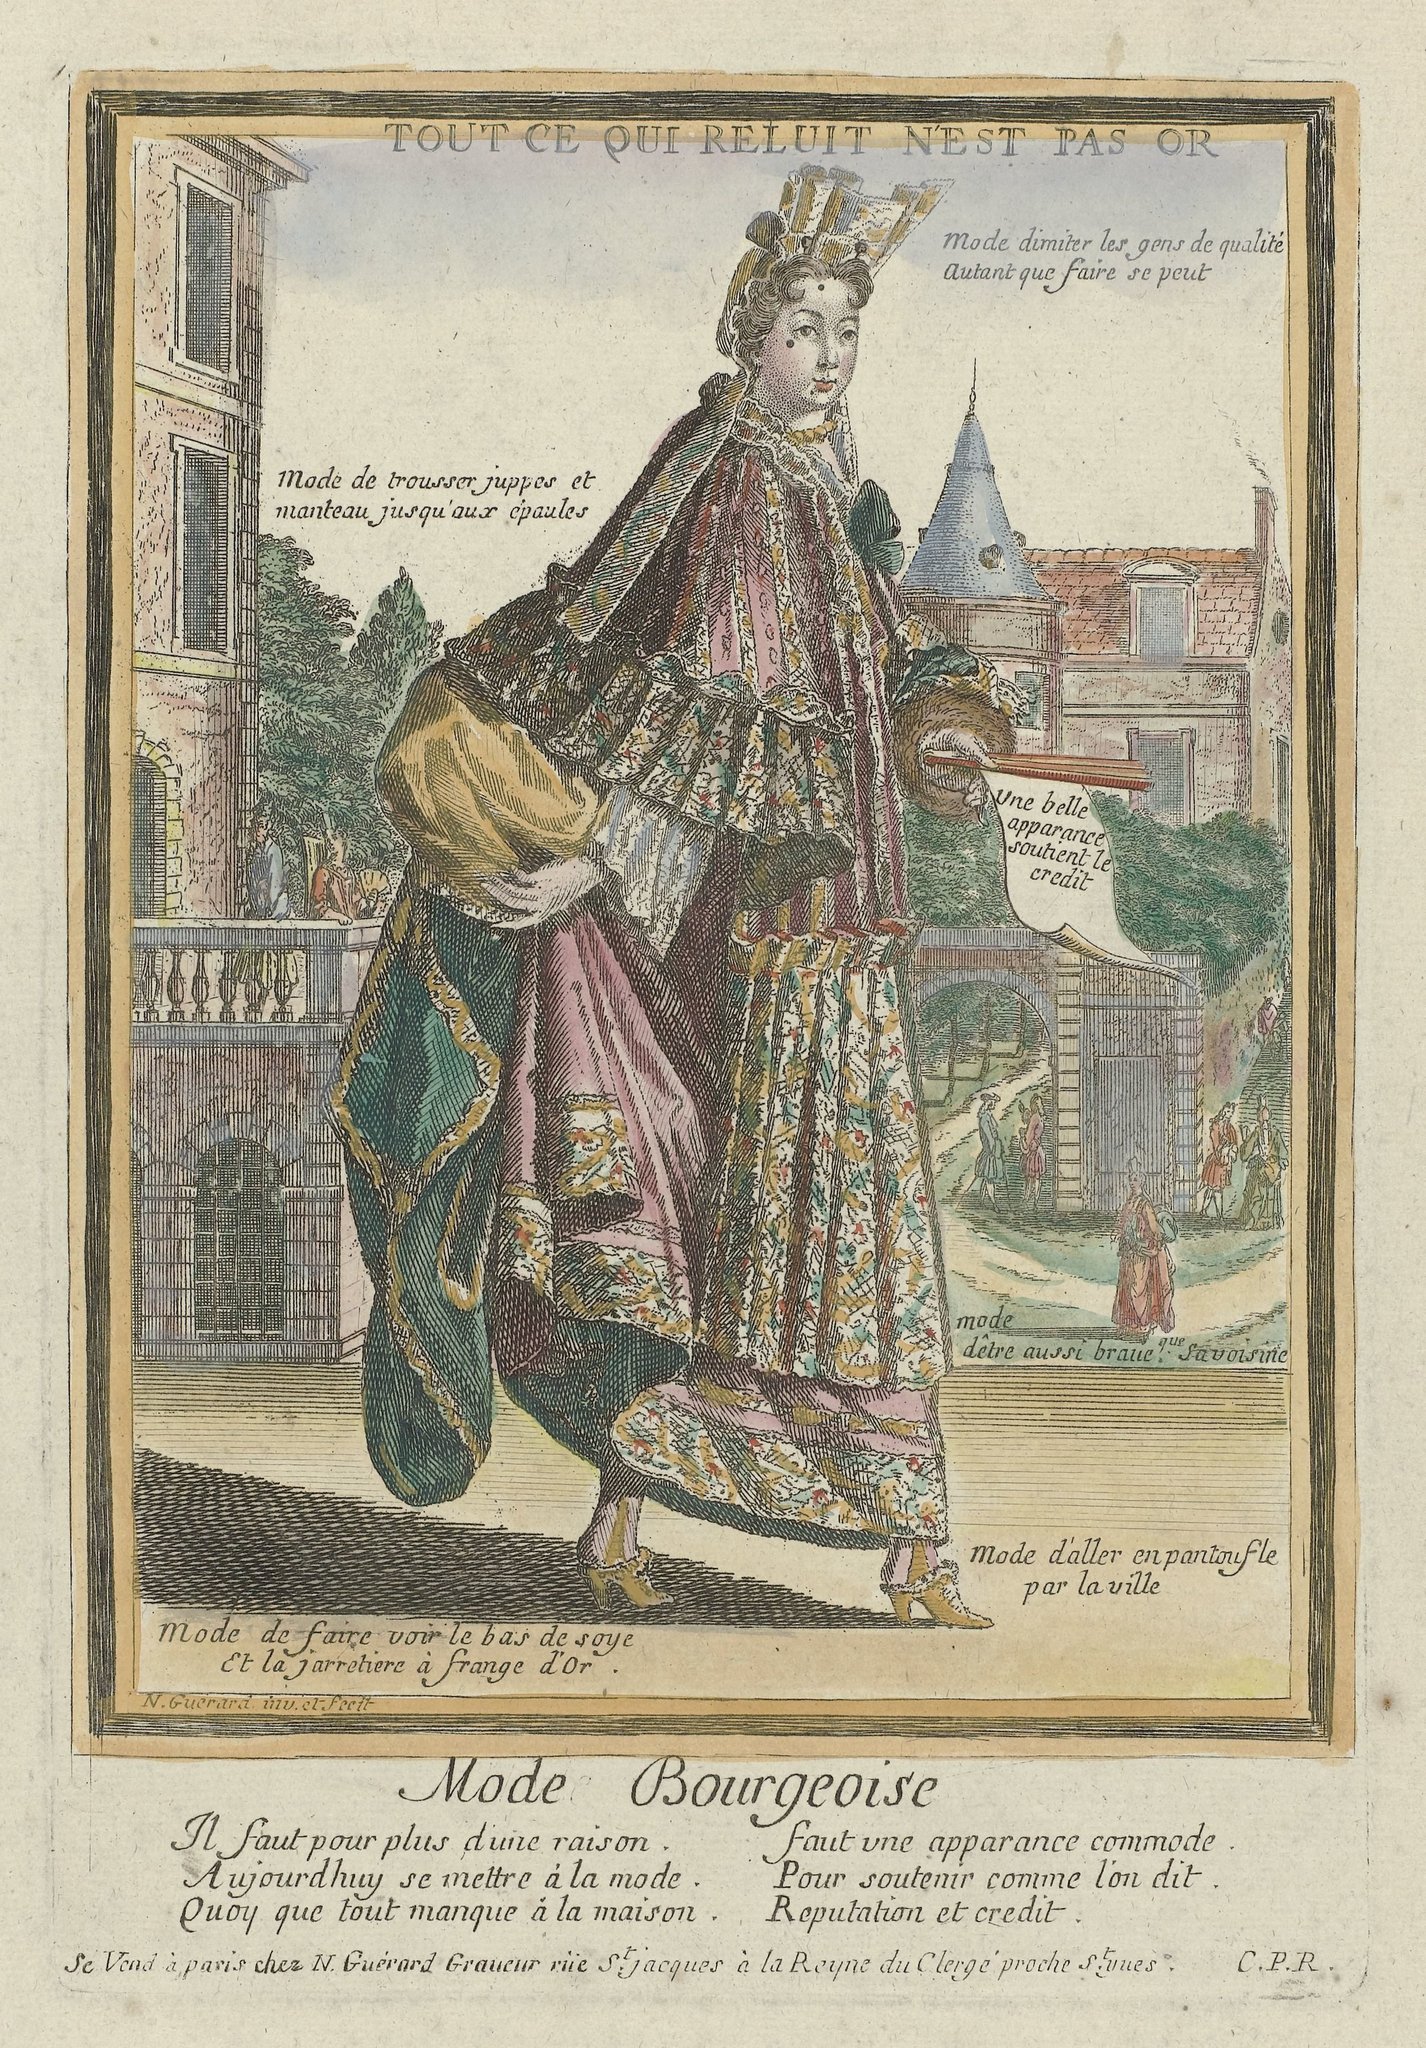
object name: costume print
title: Het is niet alles goud wat er blinkt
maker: nicolas guérard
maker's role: print maker, publisher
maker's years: 1648-1719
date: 1690-1693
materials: paper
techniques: engraving, hand coloring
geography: paris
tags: braces, suspenders, coat (+ women's clothes), styles of hairdress - aa - ~ women, fashion plates, shoes, sandals (+ women's clothes), dress, gown (+ women's clothes), fan, proverbs, sayings, etc., stockings, socks (+ women's clothes), head-gear: fontange (+ women's clothes), painting of body or face - aa - (for) women, necklace (+ women's clothes)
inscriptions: address: ‘Se vend à paris chez N. Guérard Graveur rue St. Jacques à la Reyne du Clergé proche St. Yves’, inscription: ‘Mode se trousser juppes et manteau jusqu'aux épaules’, inscription: ‘Mode d'imiter les gens de qualité / Autant que faire se peut’, inscription: ‘Une belle apparence soutient le credit’, title: ‘Mode Bourgeoise’, poem: ‘Il faut pour plus d'une raison / Aujourdhuy se mettre à la mode / Quoy que tout manque à la maison / faut une apparance commode / Pour soutenir comme l'on dit . Reputation et credit’, inscription: ‘Mode d'aller en pantoufle par la ville’, title: ‘Tout ce qui reluit n'est pas or’, inscription: ‘mode d'être aussi brave que Sa voisine’, inscription: ‘Mode de faire voir le bas de soye et la jarretiere à frange d'Or’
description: Elegante vrouw, gekleed volgens de Franse mode ca. 1690. Ze heeft een ingeklapte waaier in de hand, waaraan een vel papier hangt met de tekst: "Une belle apparence soutient le credit" (een mooie verschijning ondersteunt het aanzien) . Met 6-regelig vers in het Frans waarin wordt gesteld dat de burgerlijke mode de adel imiteert en aan de laatste mode meedoet om, kost wat kost, reputatie en aanzien op te houden. De prent maakt deel uit van een serie van 92 moralistische spreekwoorden (BN 45-137), die zijn voorzien van talloze teksten binnen in het beeld en onderschriften van 12 regels in 2 kolommen op rijm.